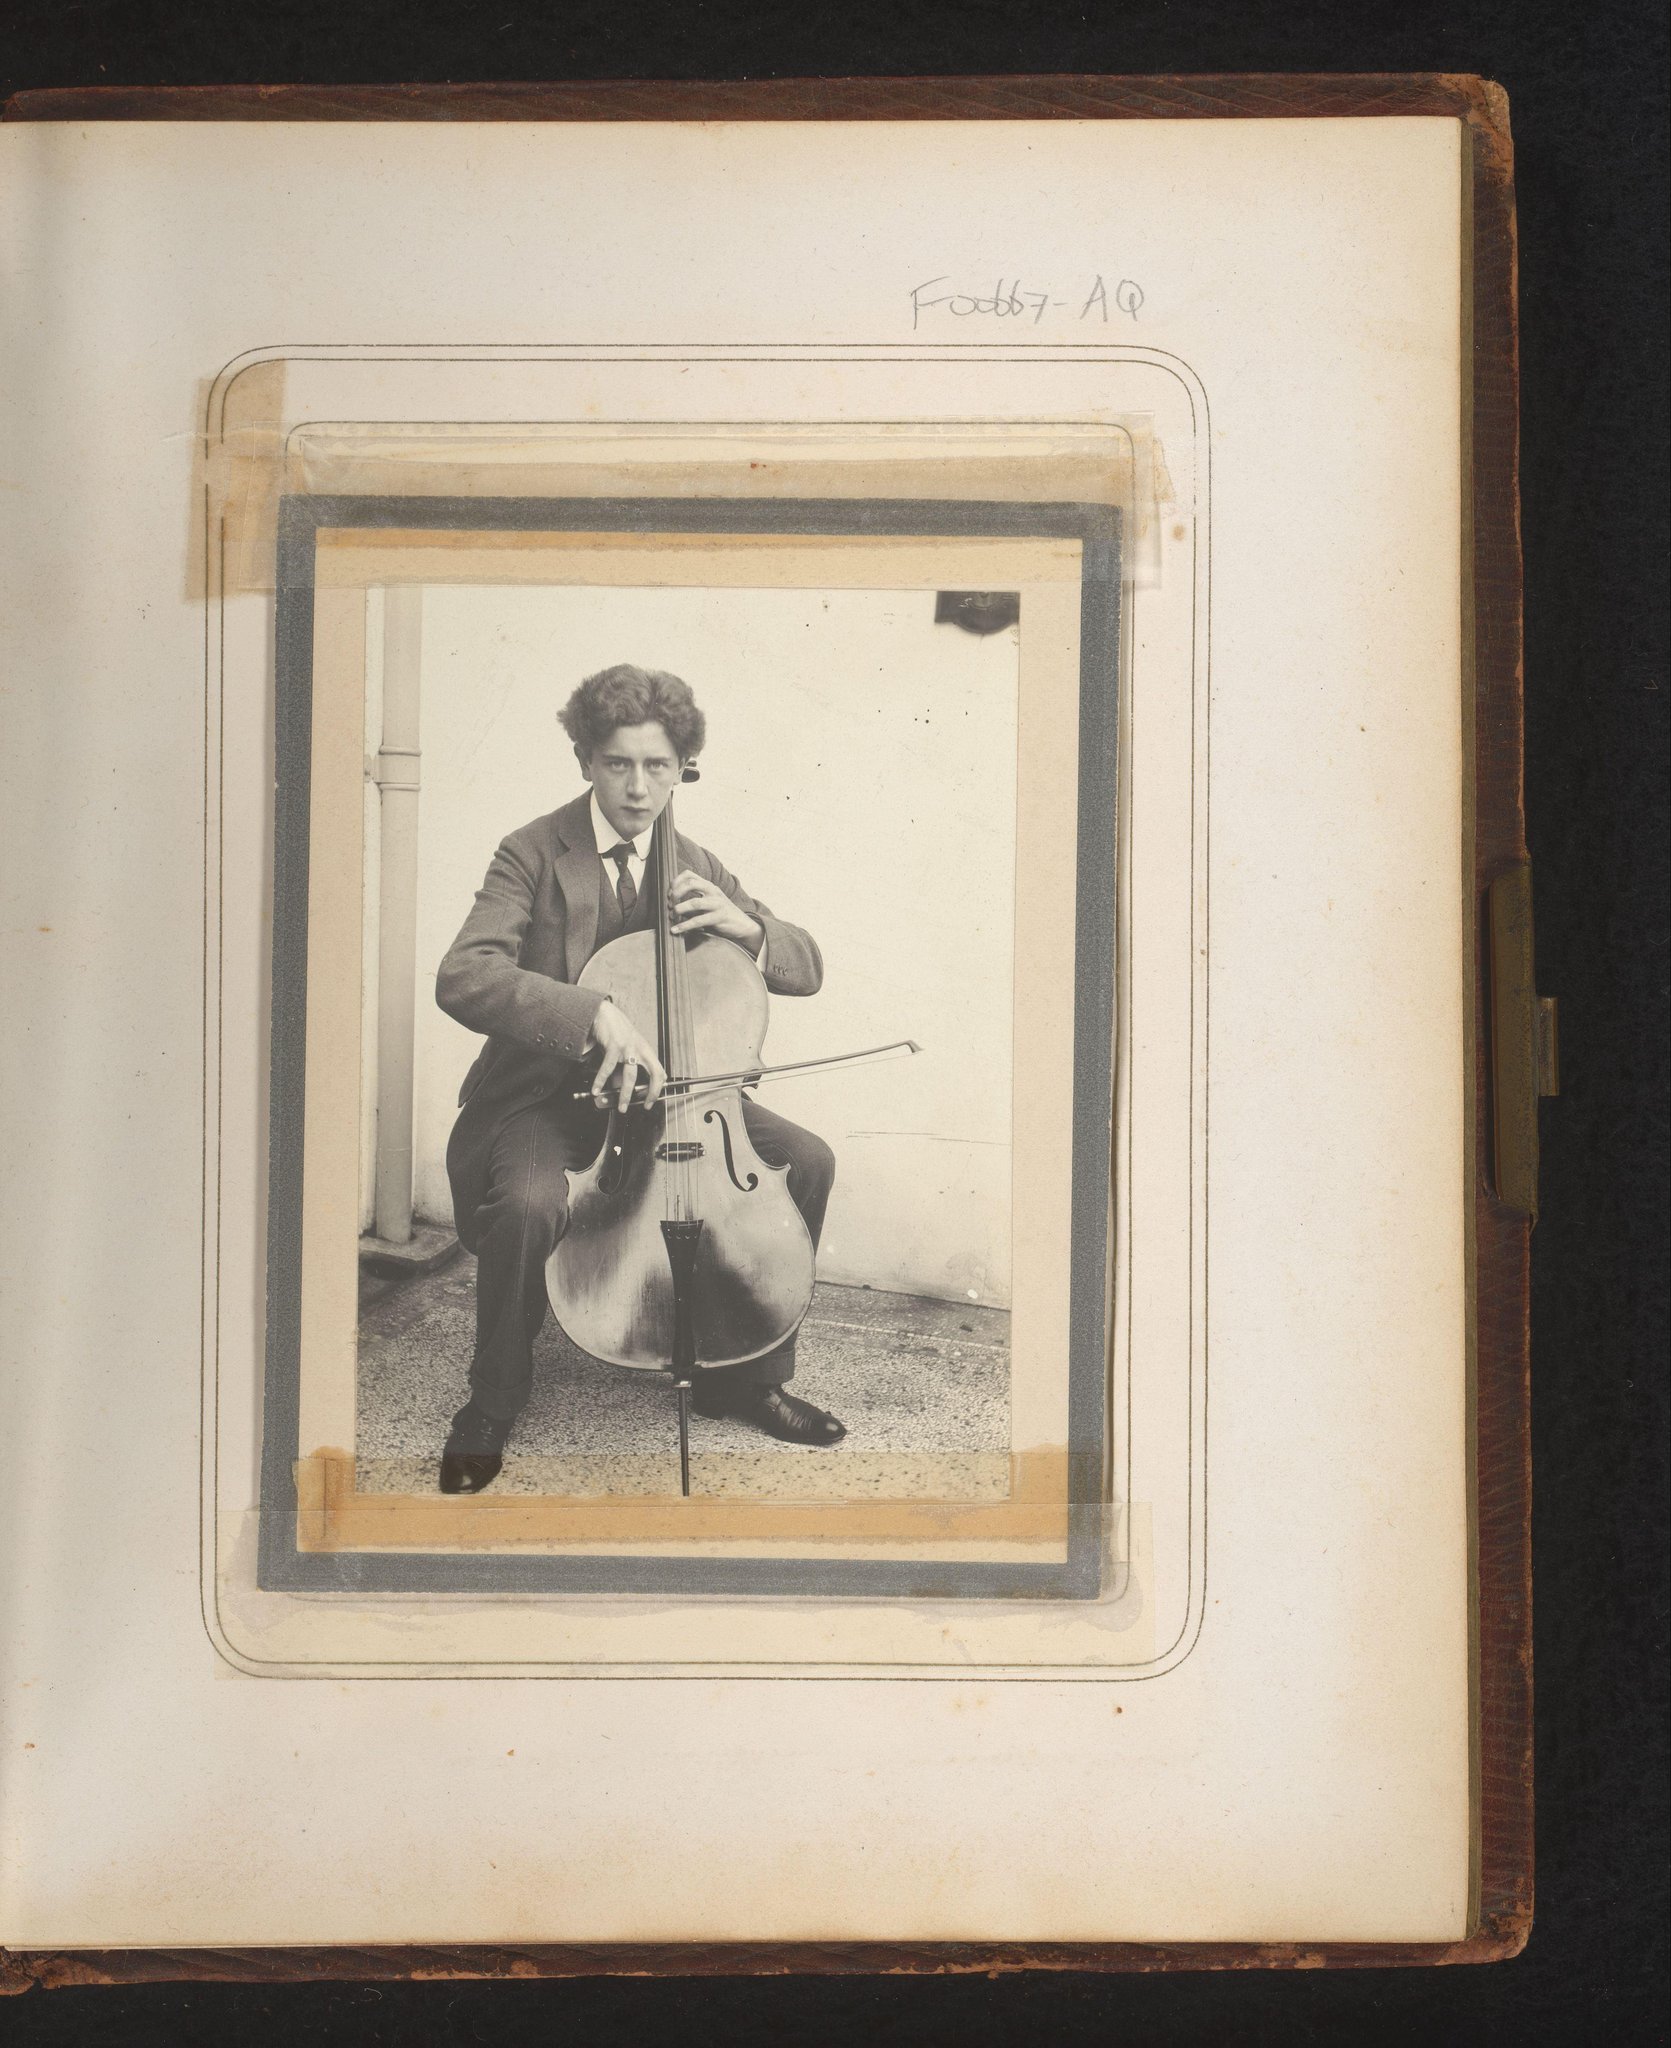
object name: album leaf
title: Portret van een jonge man die de cello bespeelt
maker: Anonymous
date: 1900-1920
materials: cardboard, photographic support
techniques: gelatin silver print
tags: youth, adolescent, viola, violoncello; double bass